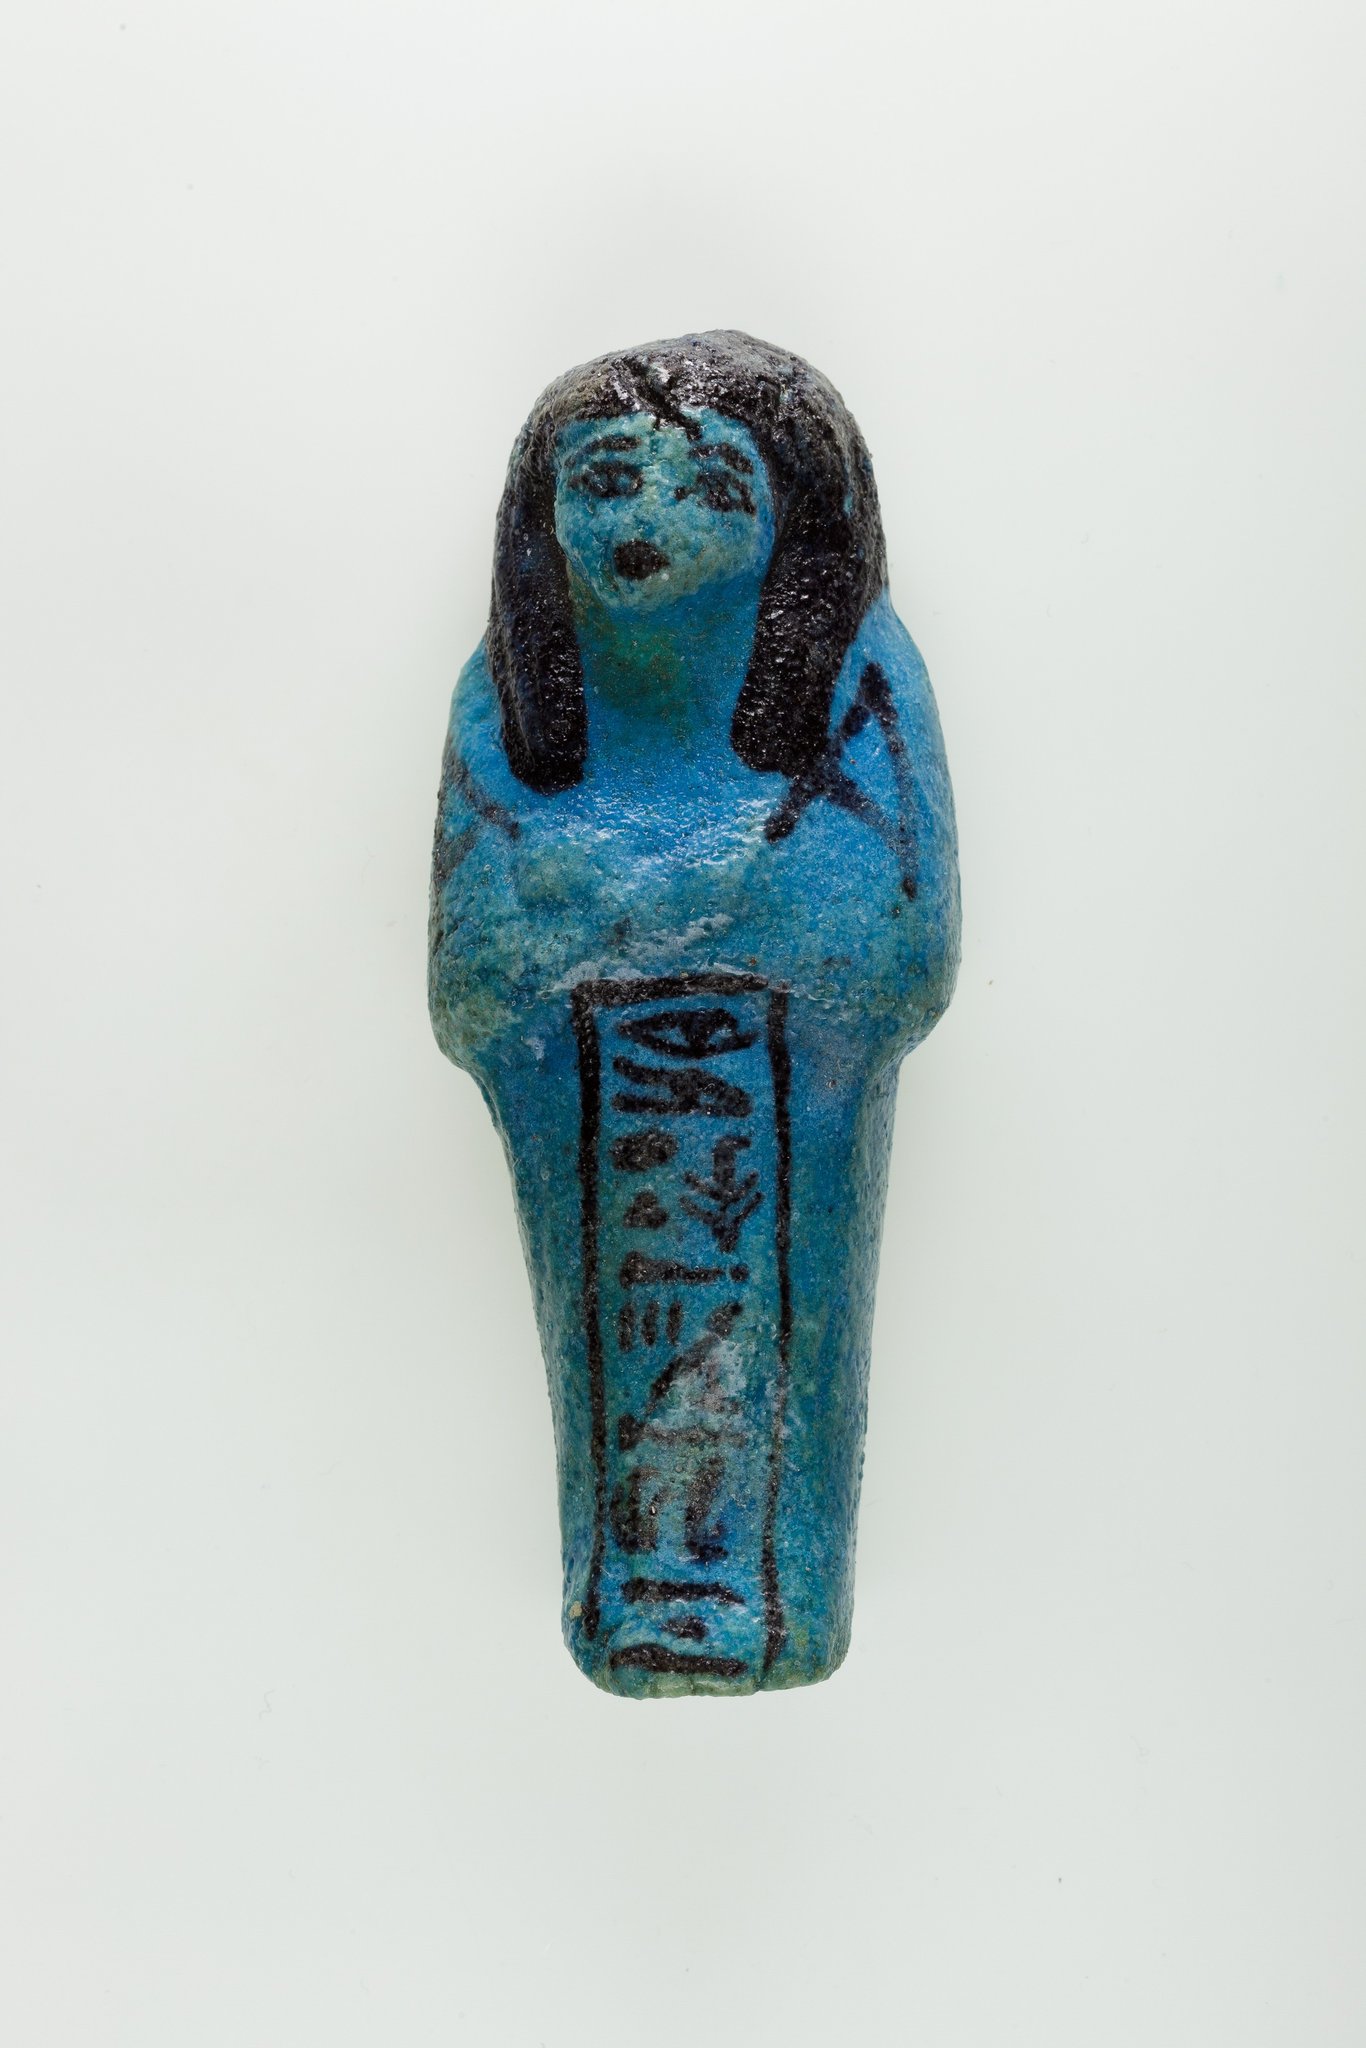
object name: shabti, worker, nauny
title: Worker Shabti of Nauny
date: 1050 BCE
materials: faience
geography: egypt